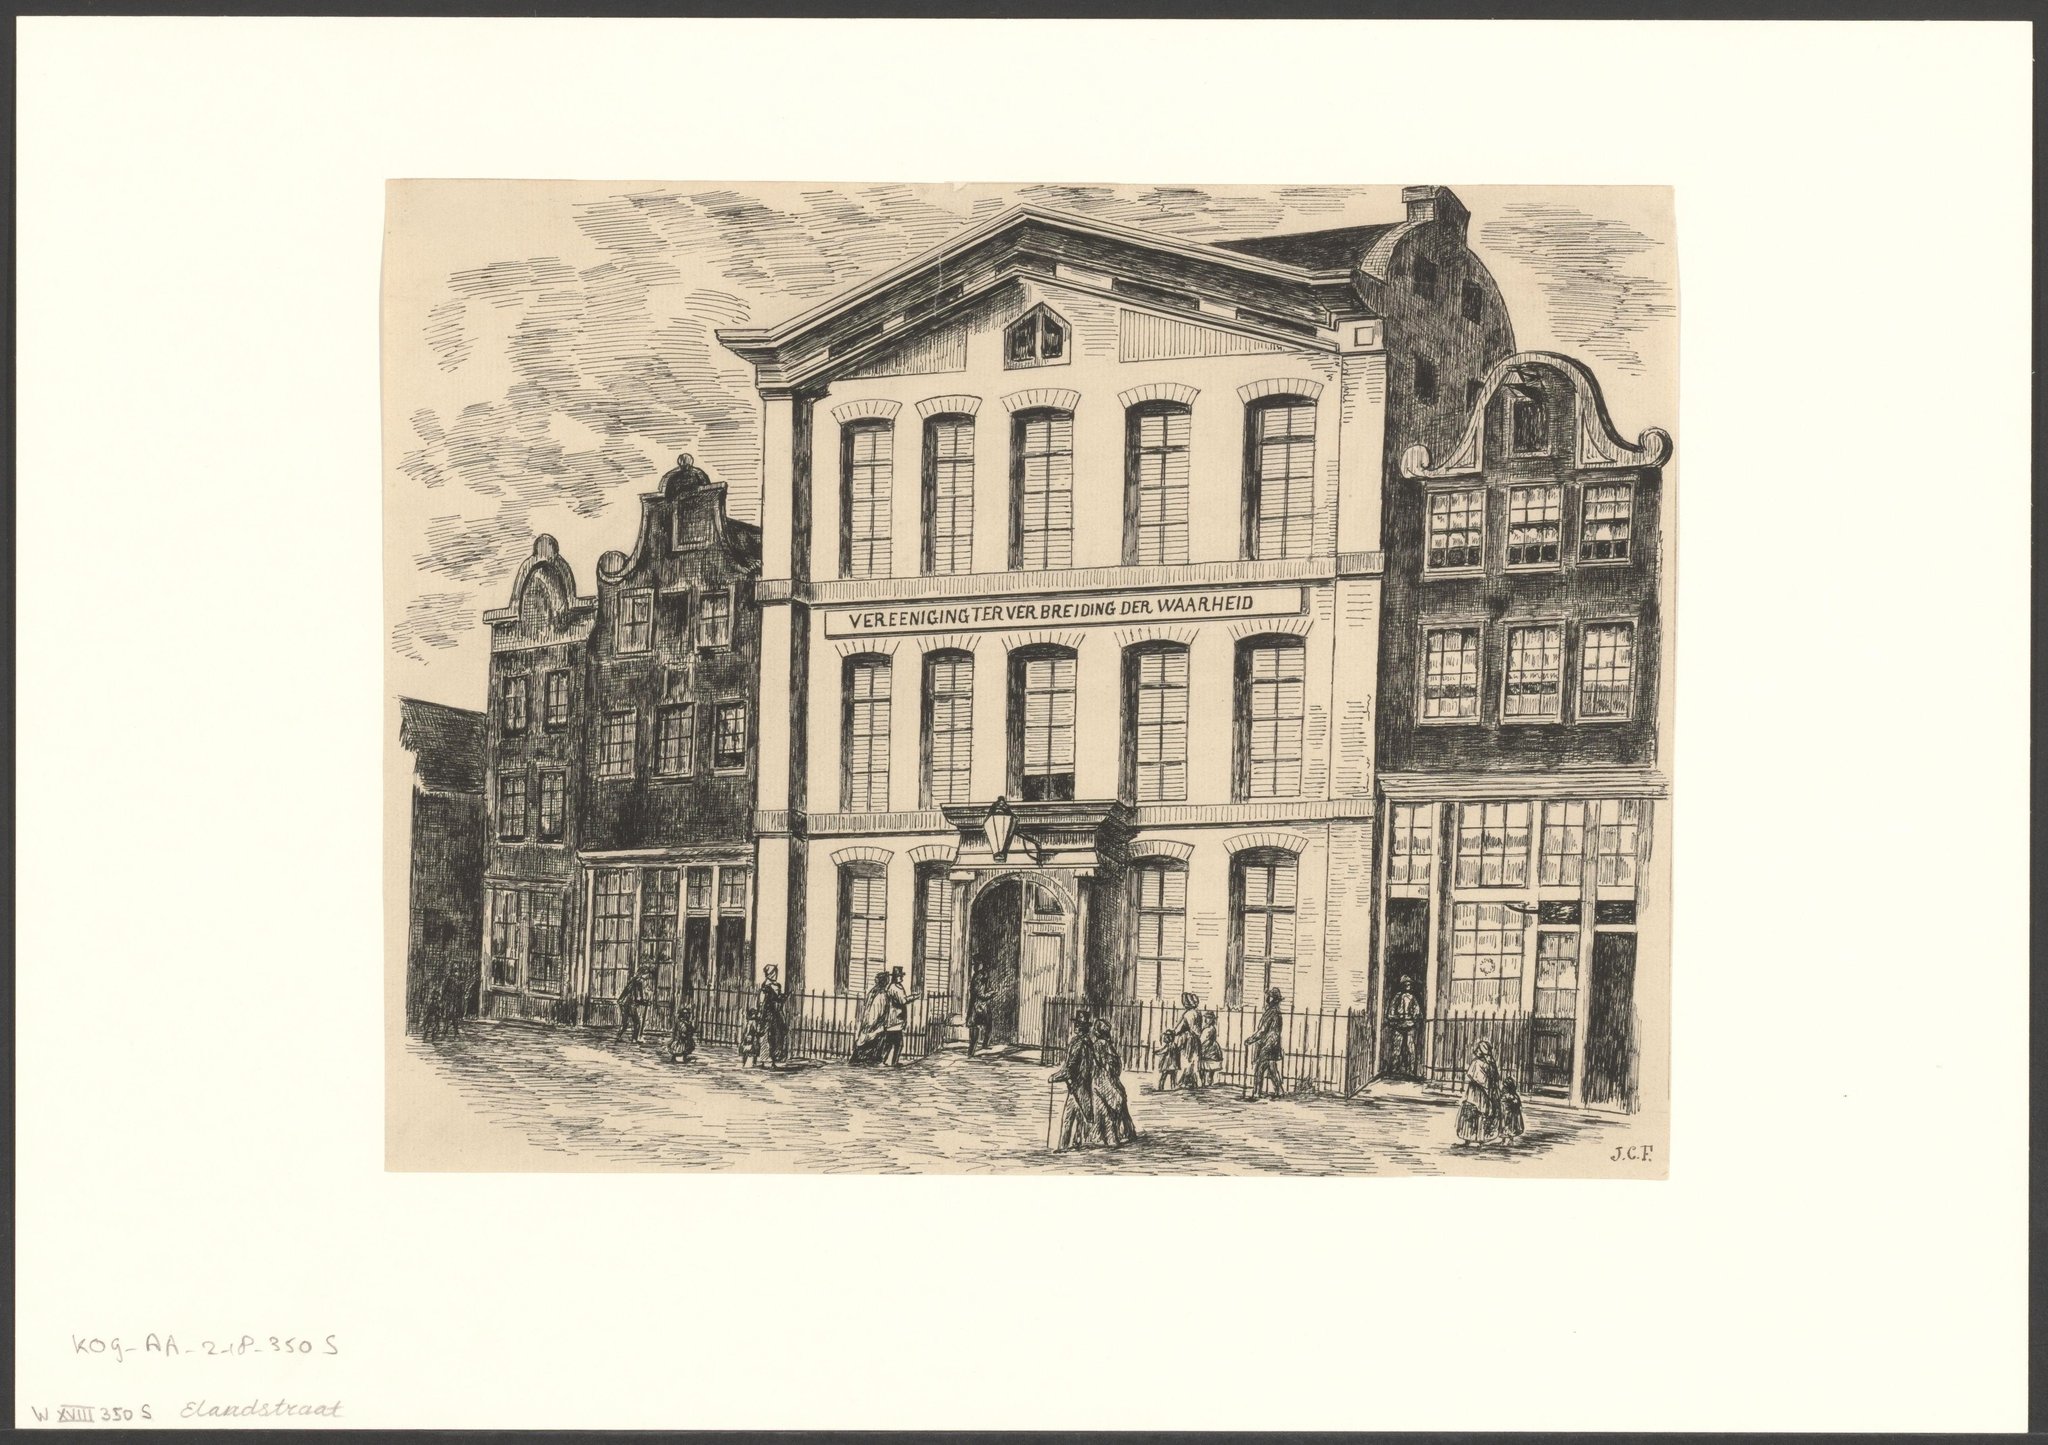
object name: drawing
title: Gezicht op het gebouw van de Vereeniging tot Verbreiding der Waarheid aan de Elandsstraat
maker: Anonymous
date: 1857-1950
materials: ink, paper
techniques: pen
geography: amsterdam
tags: city-view in general; 'veduta', façade (of house or building), street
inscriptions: signature: ‘J.C.F’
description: Tekening binnen de Atlas Van Eck ingedeeld op wijknummer 18.